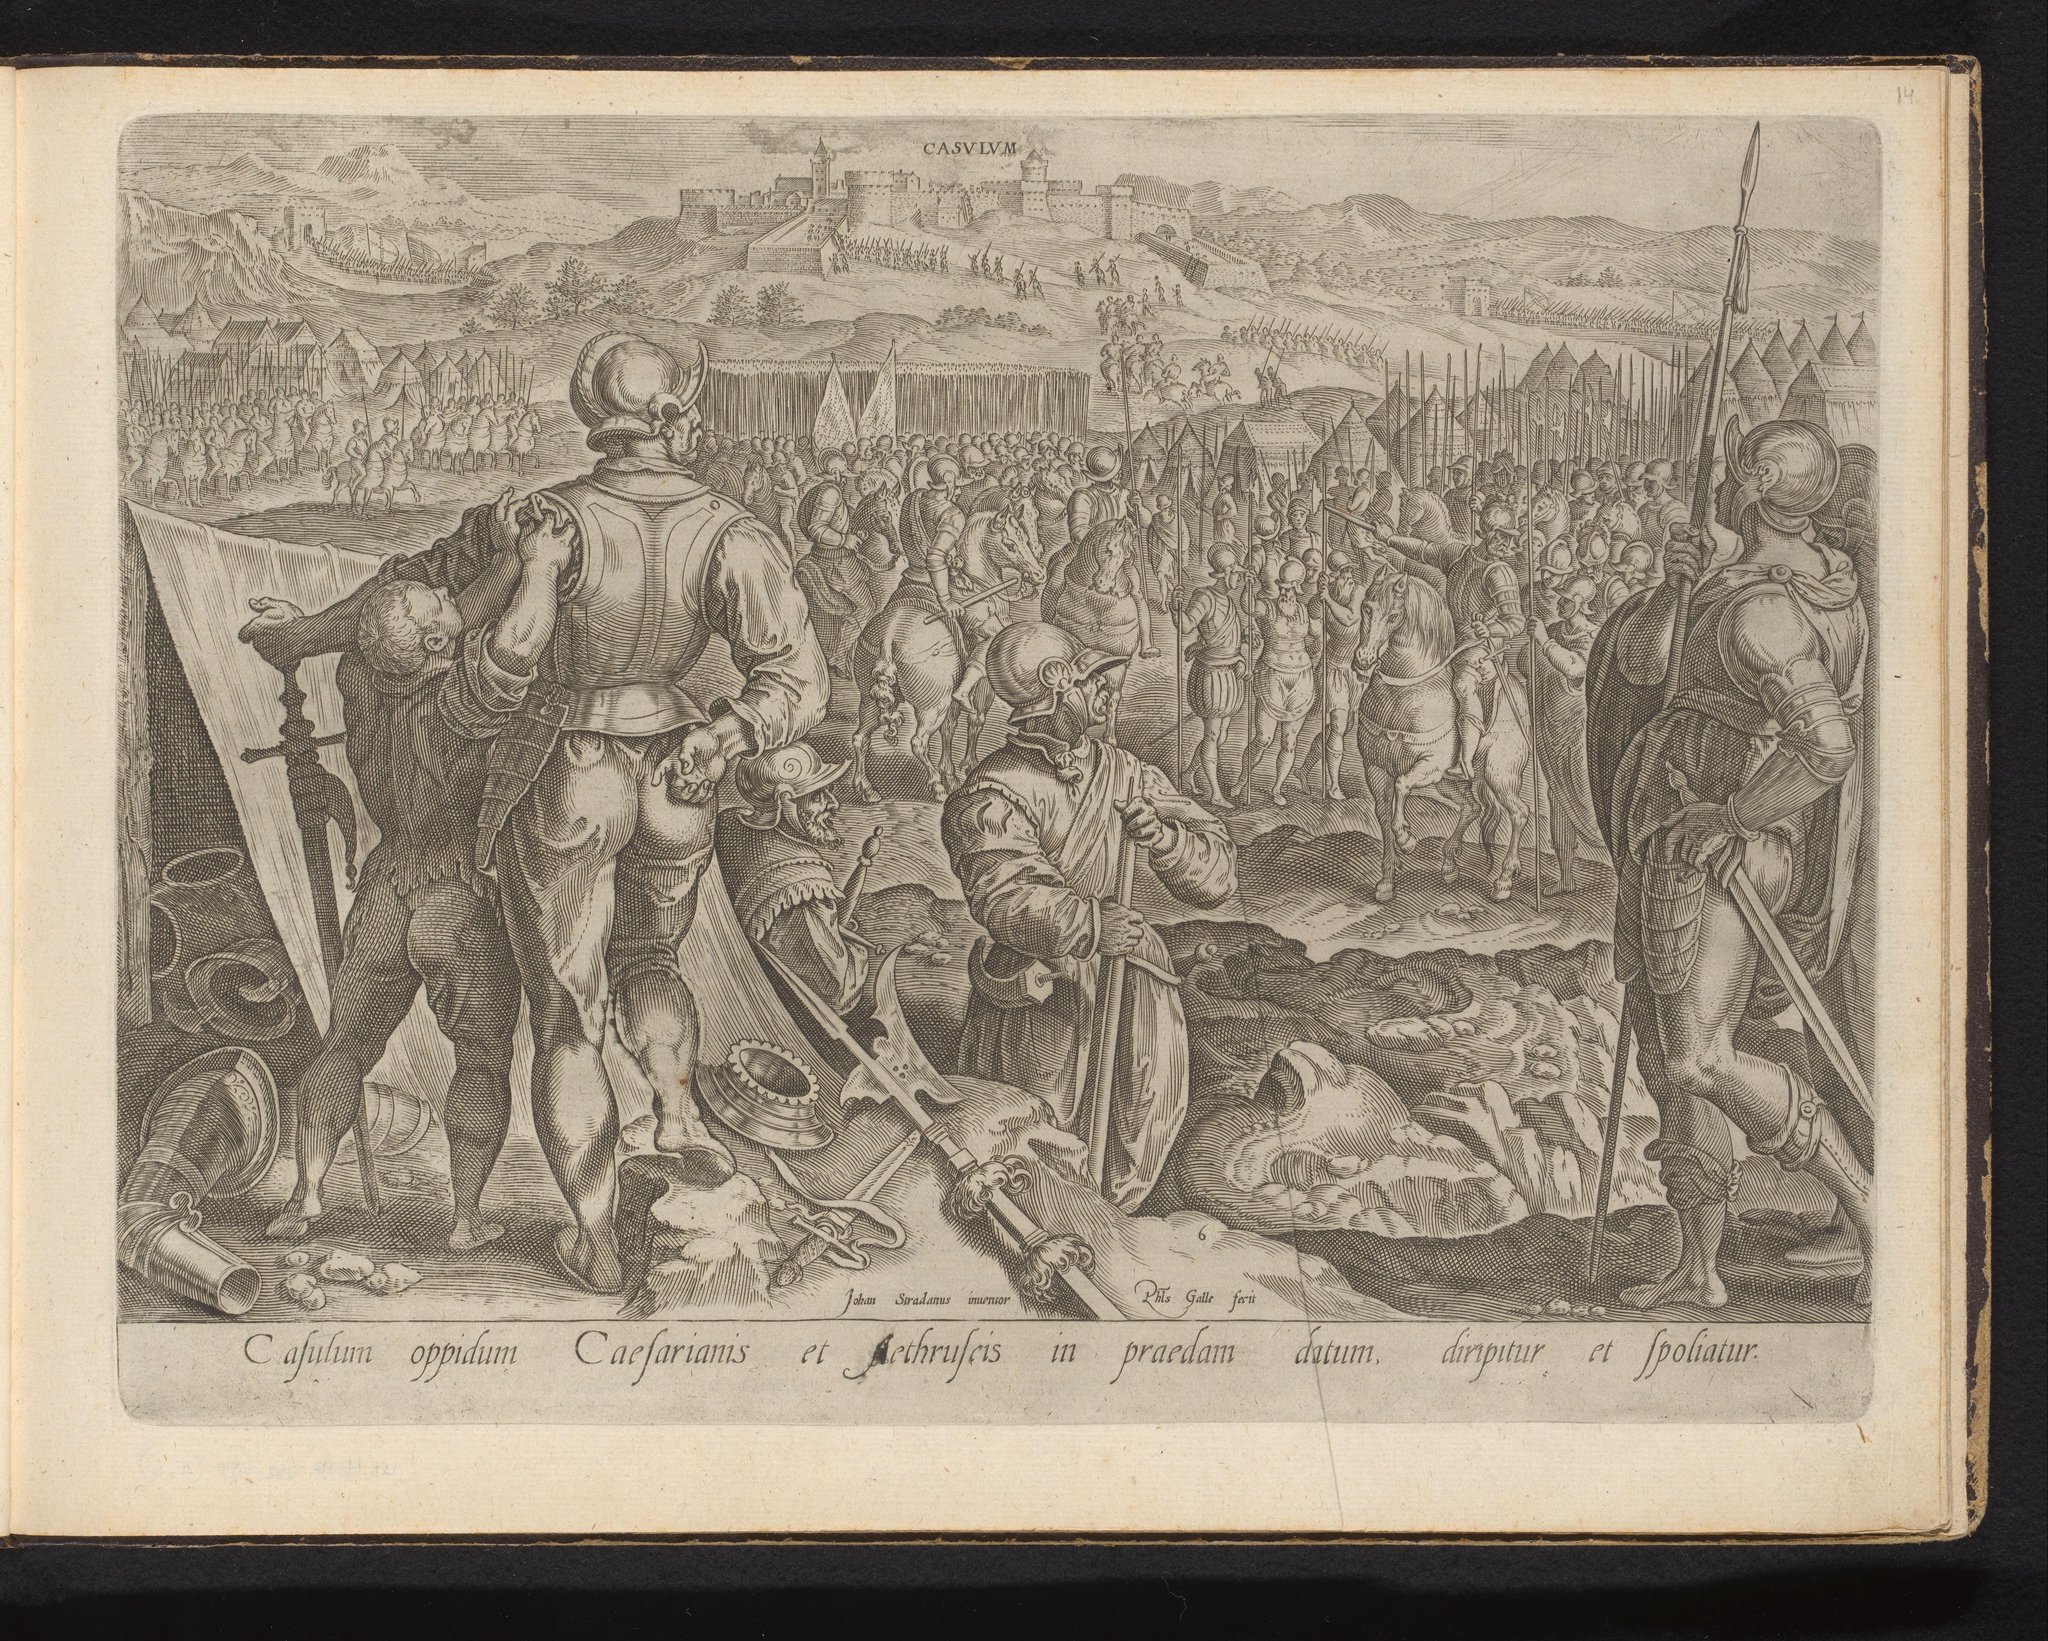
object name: history print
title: Mediceae Familiae rerum feliciter gestarum victoriae et triumphi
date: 1583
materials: paper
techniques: engraving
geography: antwerp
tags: cosimo i de' medici, siege, position war, armour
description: Beleg en inname van Casole d'Elsa. Links op de voorgrond trekt een soldaat met behulp van zijn knecht zijn wapenuitrusting aan. Een andere soldaat laadt zijn musket. In de ondermarge twee regels tekst in het Latijn. Genummerd 6. De prent maakt deel uit van een album.